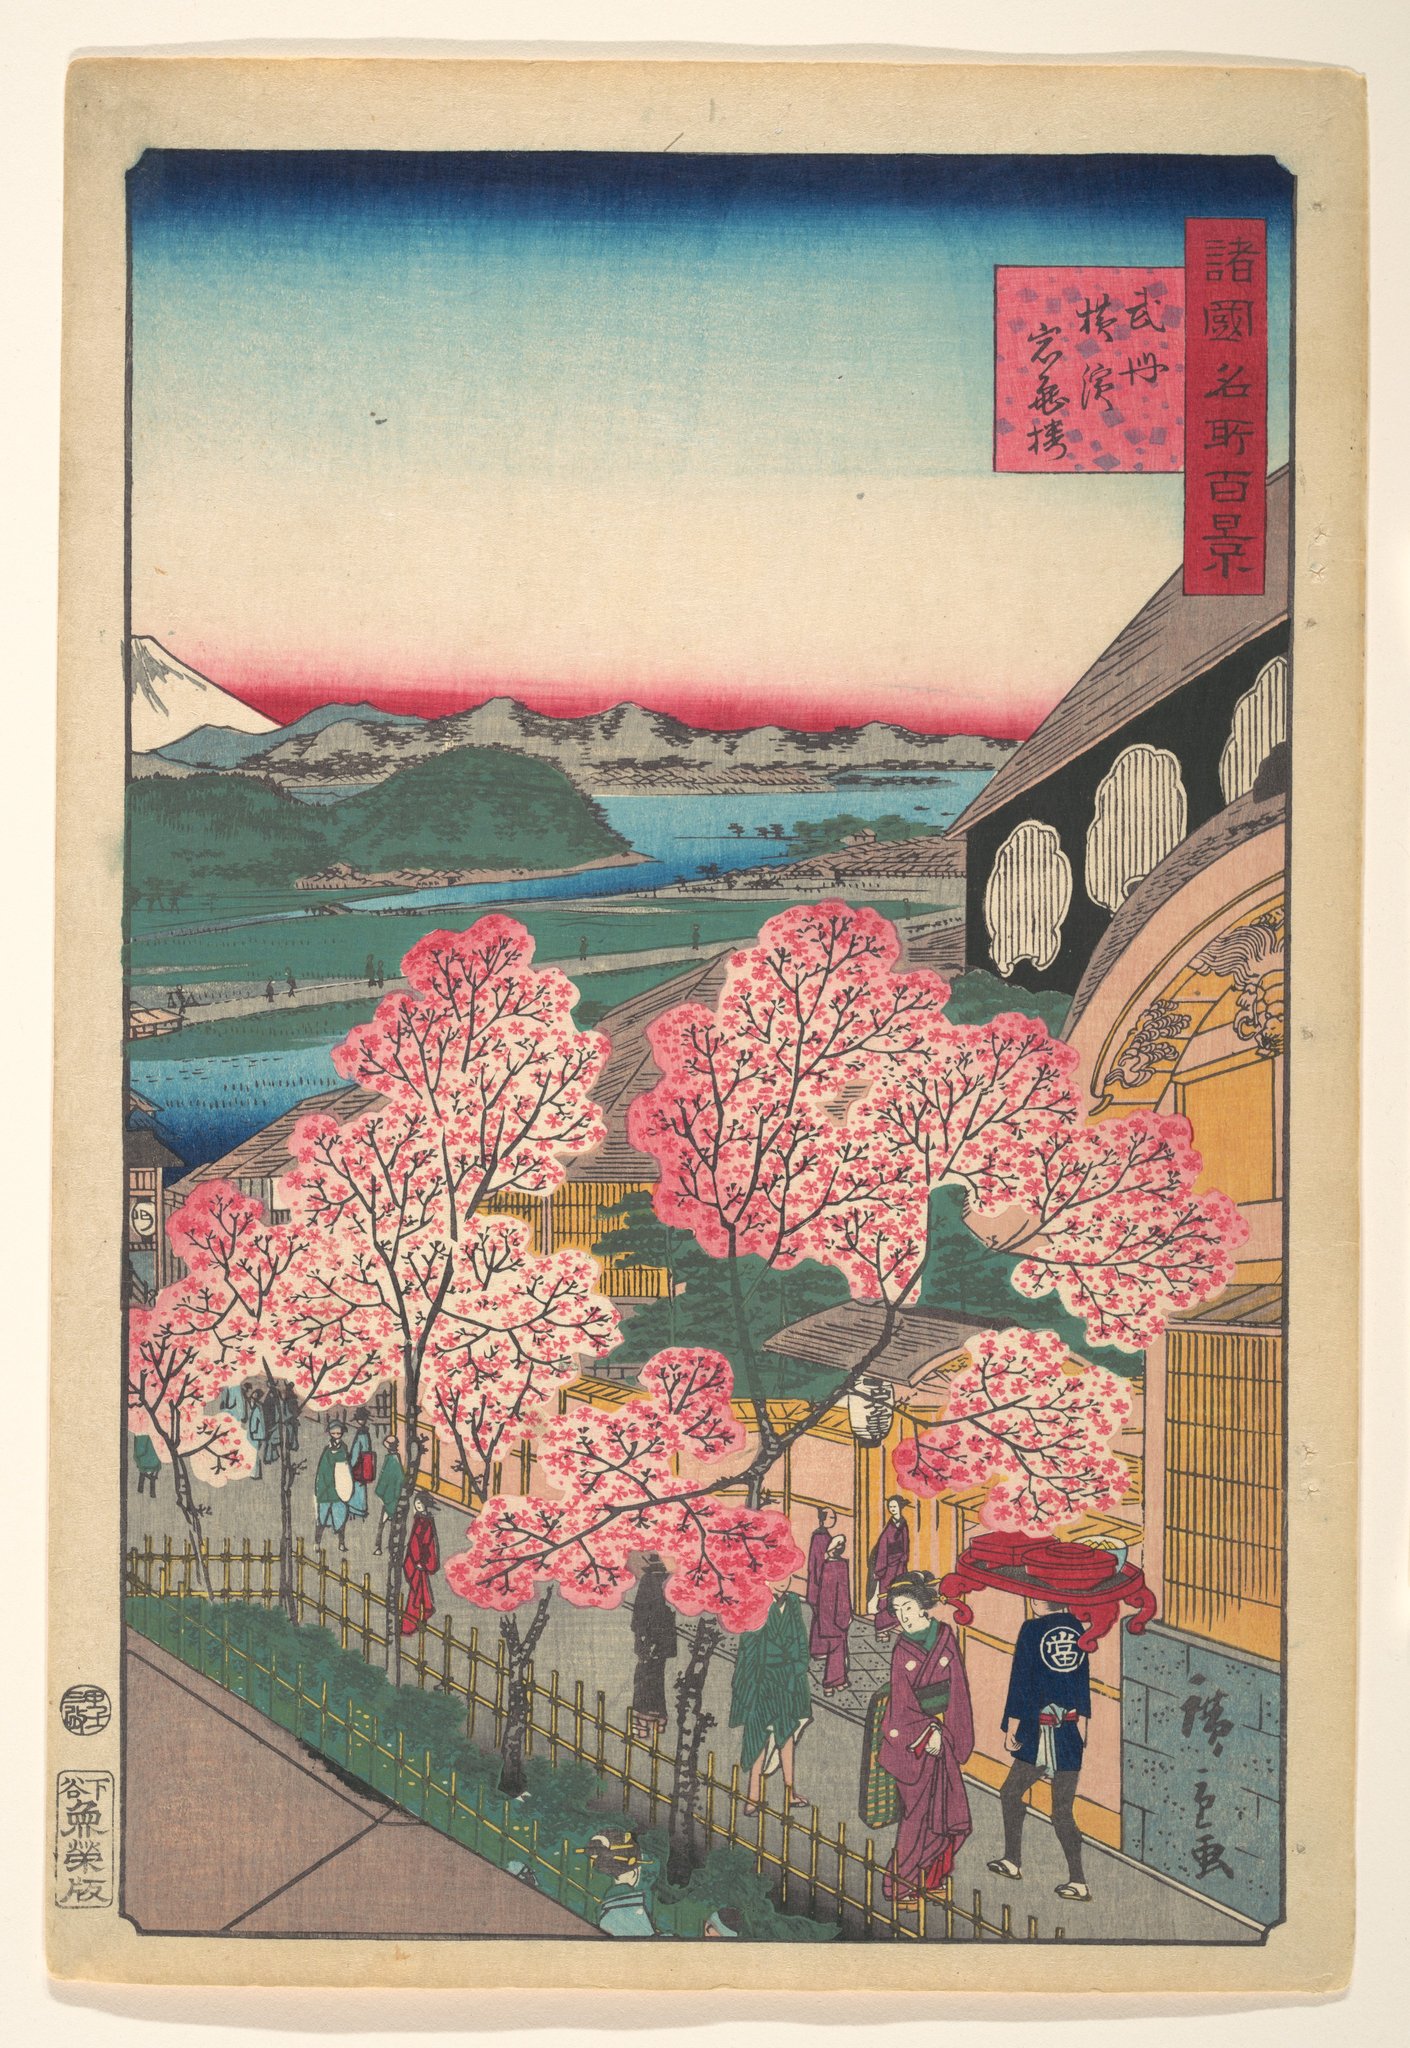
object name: print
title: Entrance to the Gankirō Tea House in the Miyozaki District, Yokohama, Bushu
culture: japanese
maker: utagawa hiroshige ii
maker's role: artist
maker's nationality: japanese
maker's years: 1826-1869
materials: ink, paper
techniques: woodblock print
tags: men,women,walking,landscapes,trees